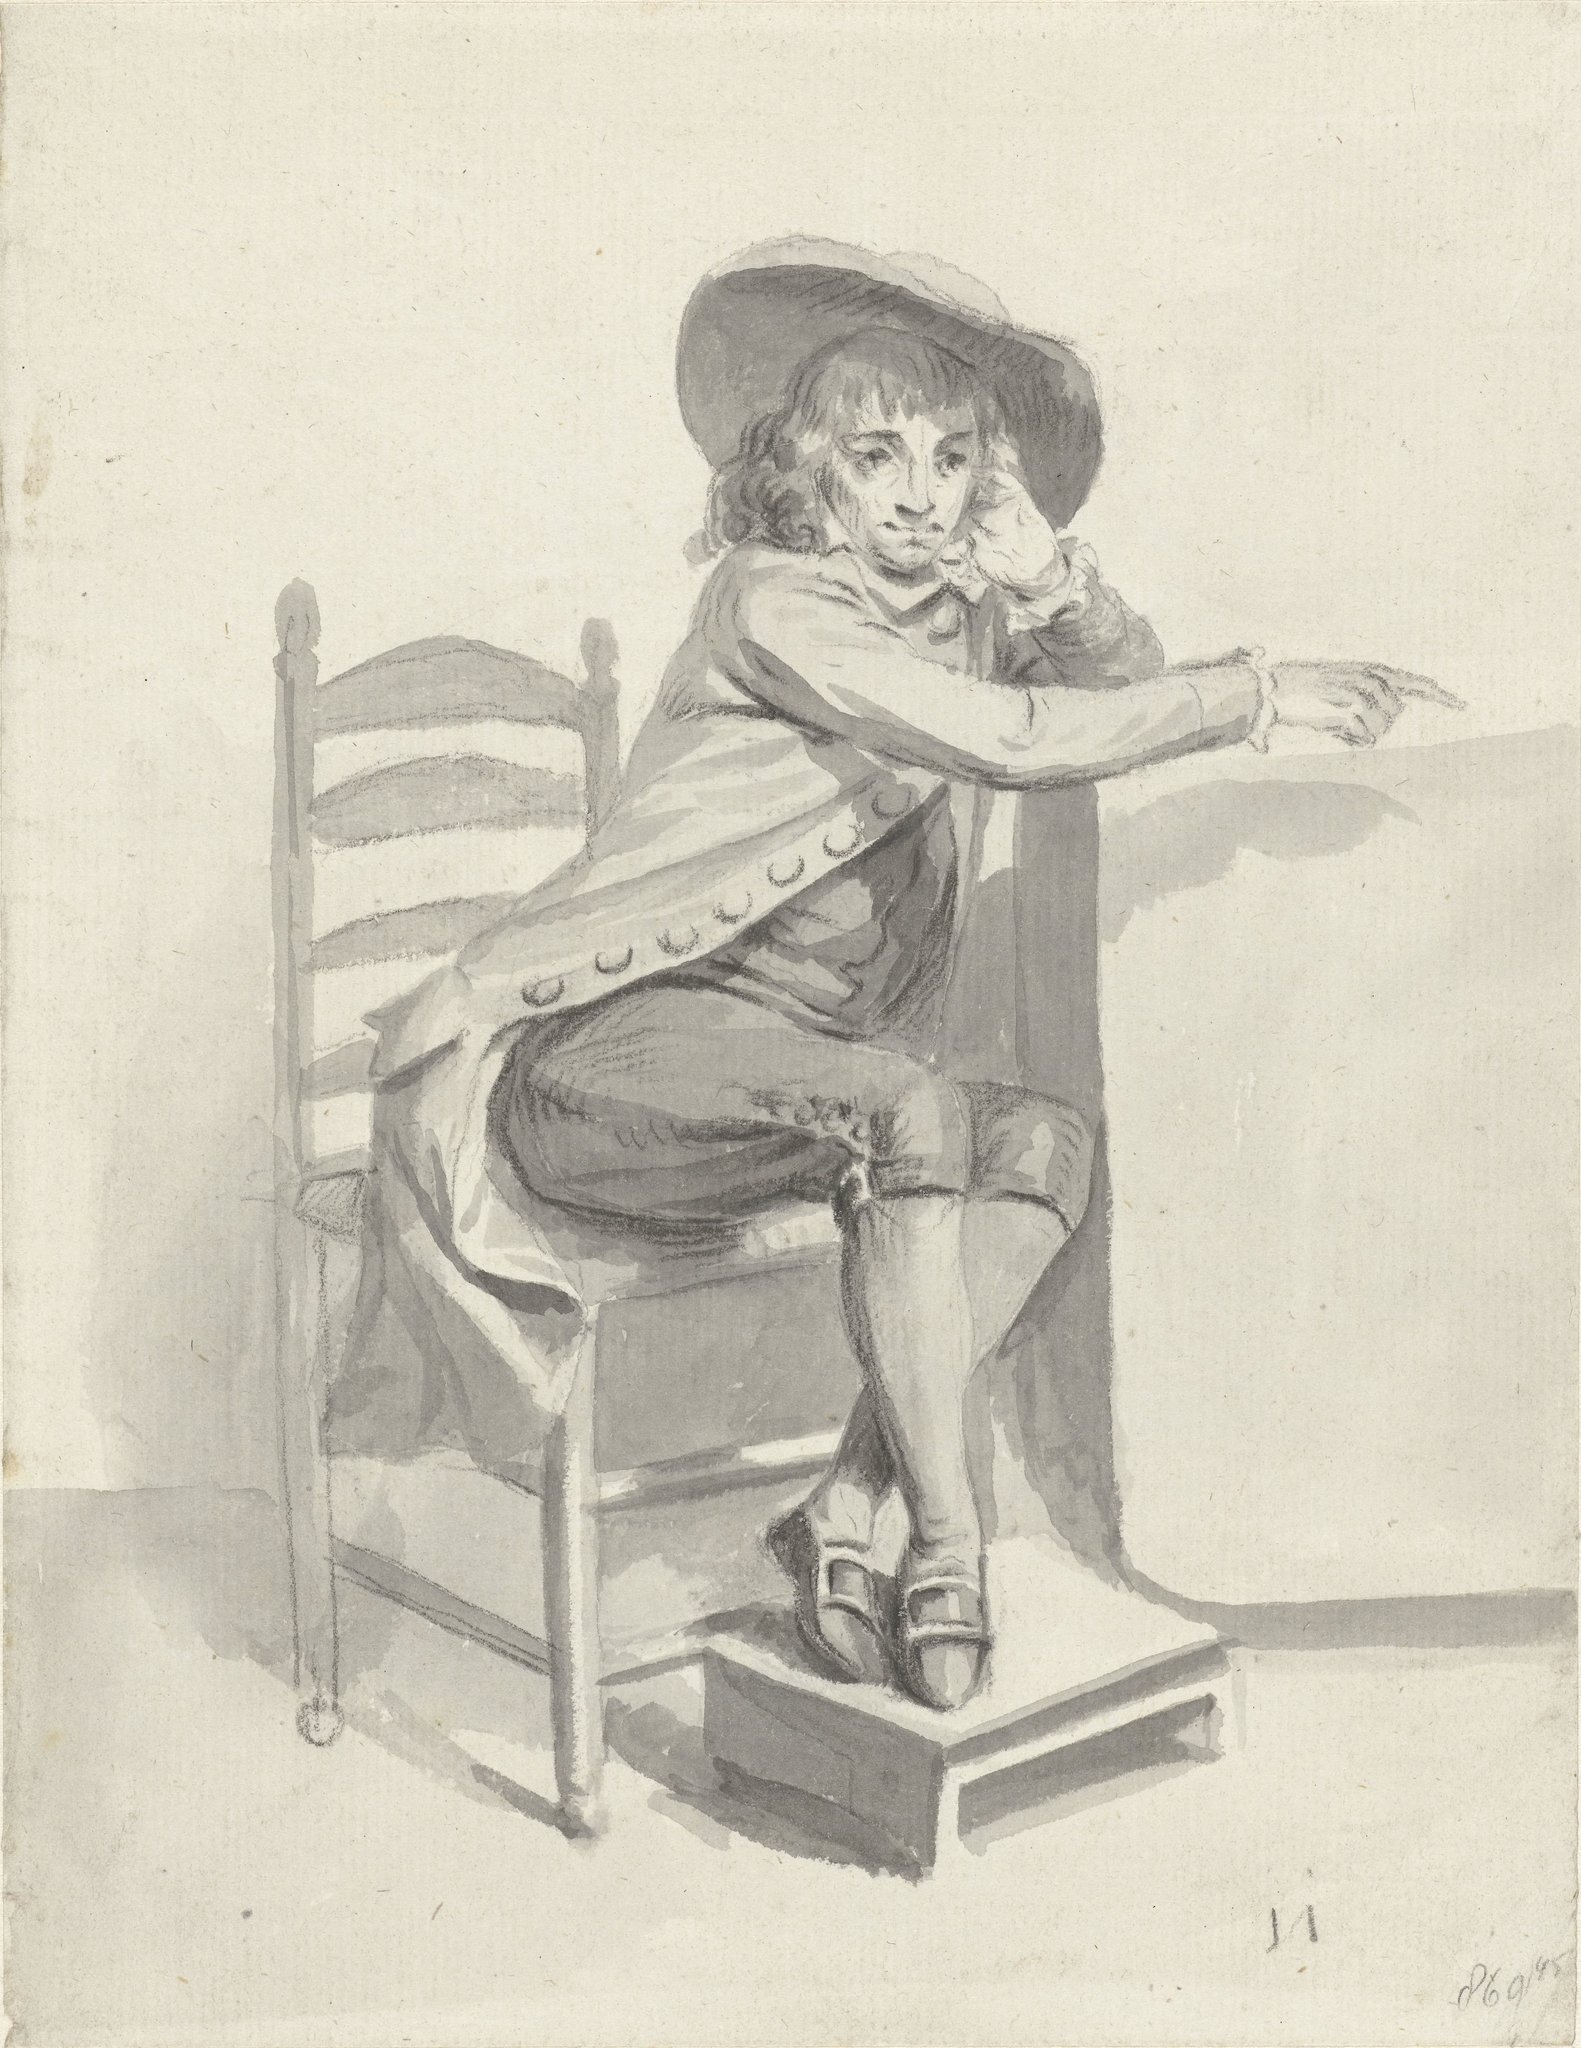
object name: drawing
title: Jongen zittend op een stoel, wijzend naar rechts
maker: taco scheltema (i)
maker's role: draughtsman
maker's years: 1760-1837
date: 1770-1837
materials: chalk, paper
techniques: brush